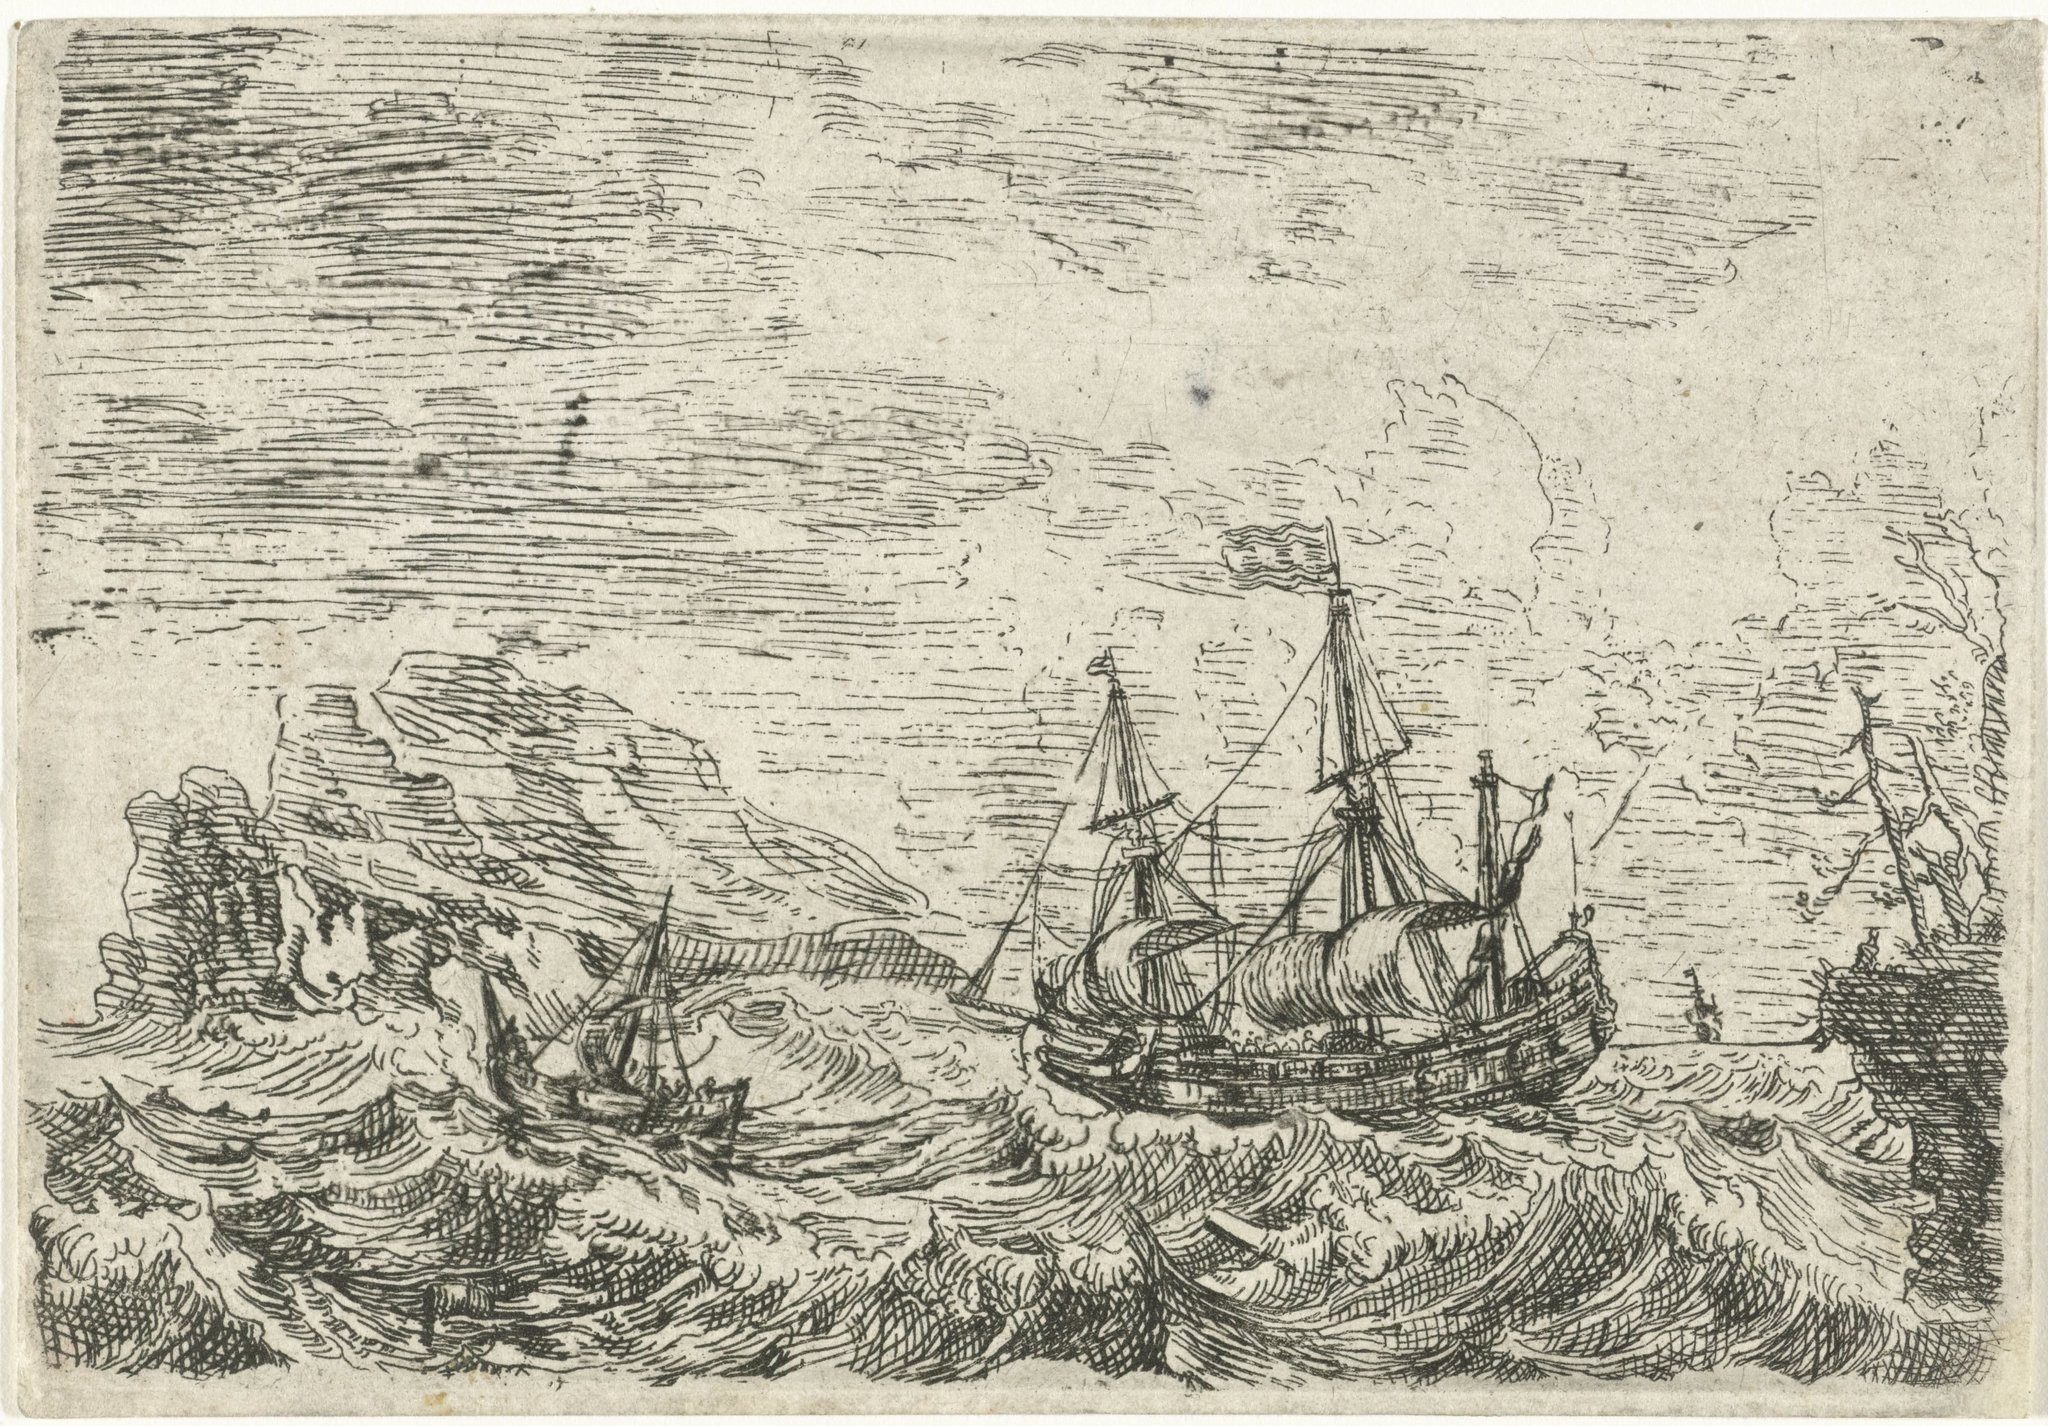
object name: print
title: Schepen op een woeste zee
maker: bonaventura peeters (i)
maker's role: draughtsman, painter, print maker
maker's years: 1614-1652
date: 1624-1652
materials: paper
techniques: etching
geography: antwerp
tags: storm at sea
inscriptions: collector's mark: Lugt 2228